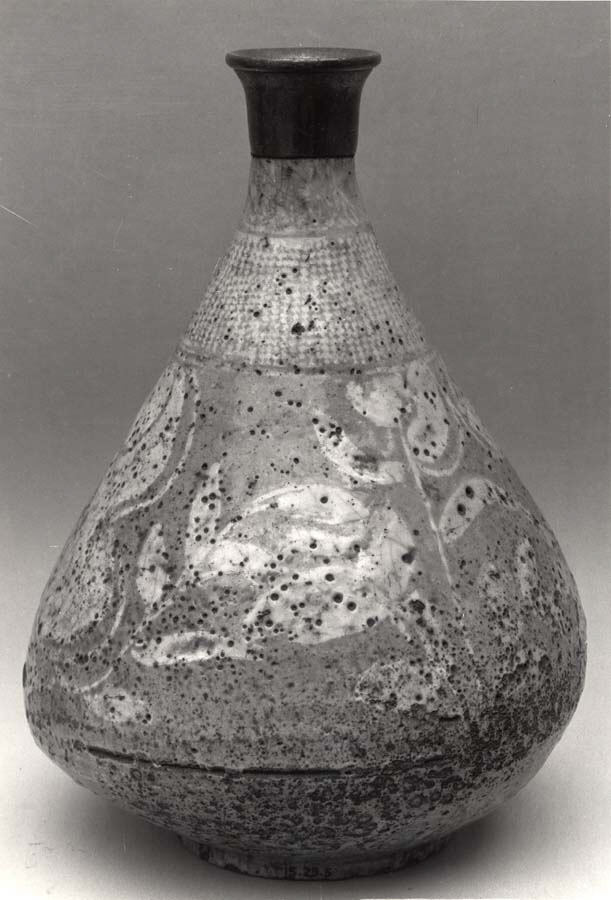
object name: bottle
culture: korean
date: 1901-1933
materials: glaze, stoneware